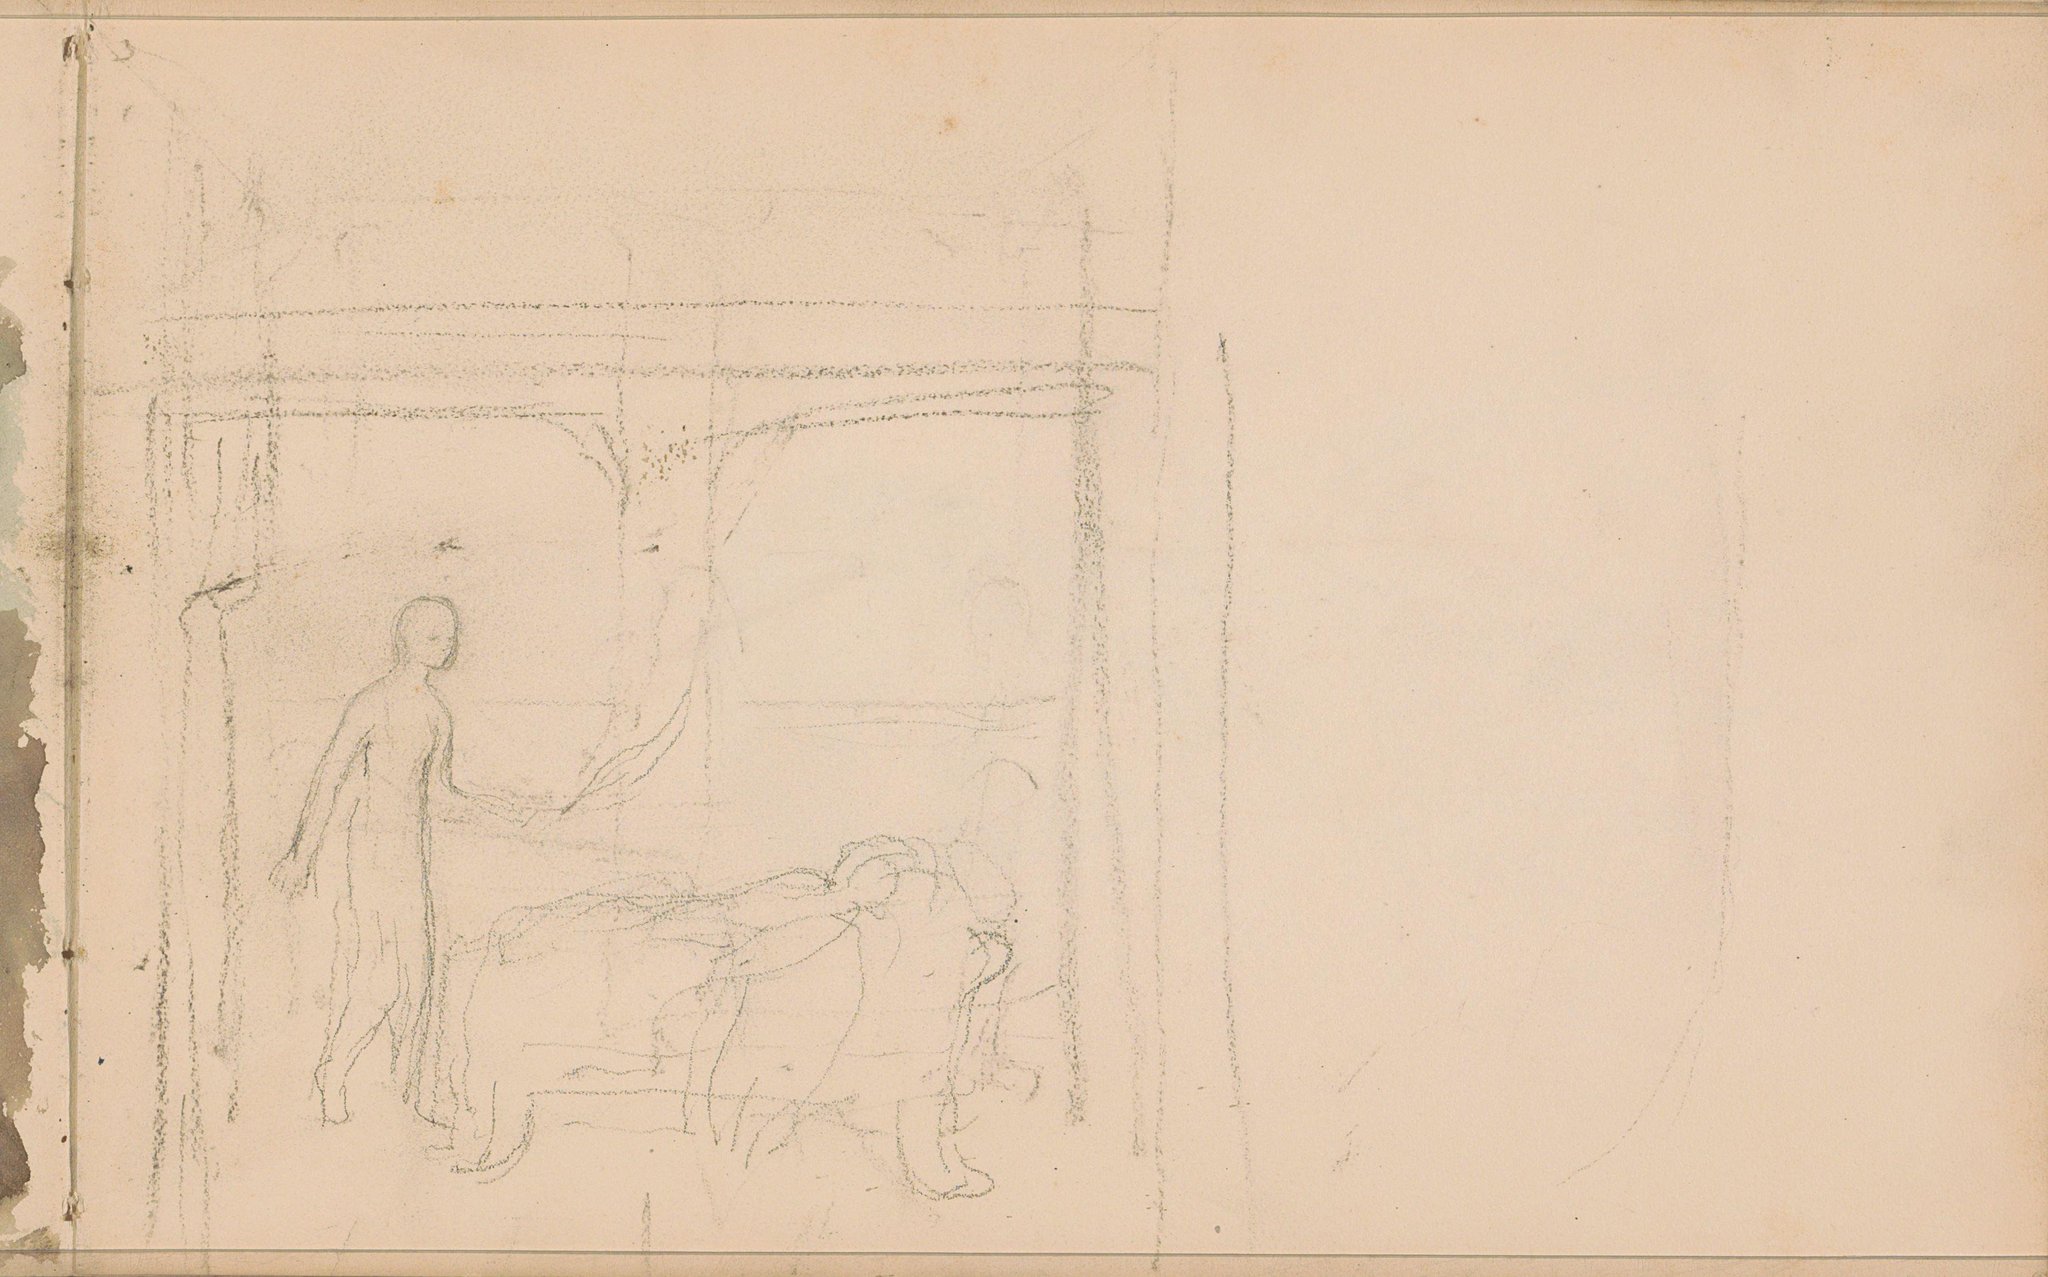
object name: sketchbook leaf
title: Figuur, mogelijk een herder, bij een groep vee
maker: a.a.l. de grammont-hubrecht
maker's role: draughtsman, painter, print maker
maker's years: 1855-1913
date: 1865-1913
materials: chalk, paper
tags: herding, herdsman, herdswoman, shepherd, shepherdess, cowherd, etc., cattle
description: Blad 27 recto uit een schetsboek met 65 bladen.